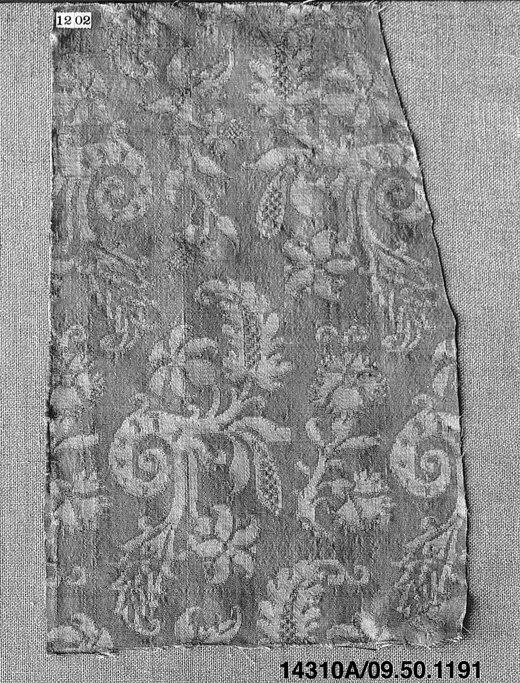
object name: piece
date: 1501-1600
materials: silk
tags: leaves